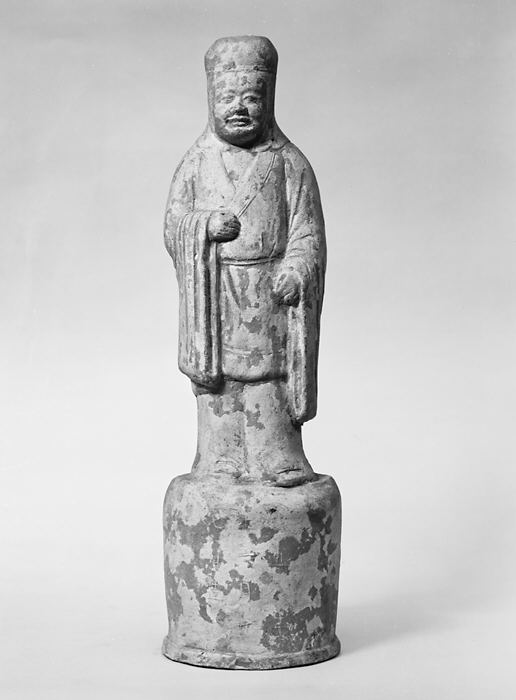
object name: statuette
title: Official Standing on High Base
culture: chinese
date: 801-900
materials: terracotta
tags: men